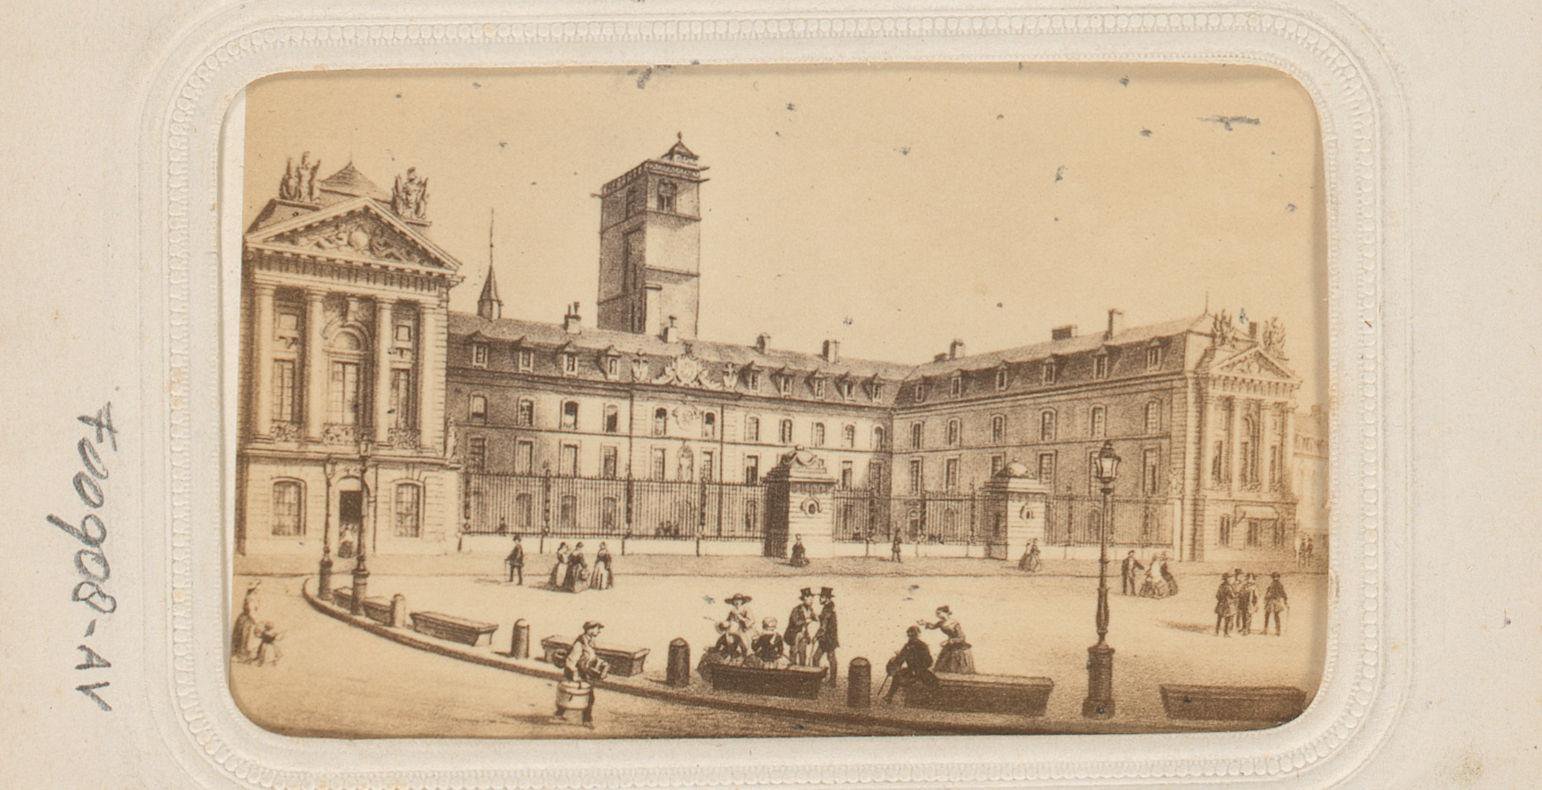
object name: reproduction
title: Fotoreproductie van een prent van het Paleis van de hertogen van Bourgondië te Dijon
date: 1860-1885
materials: cardboard, photographic support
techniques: albumen print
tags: palace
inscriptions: annotation: ‘Paleis der hertogen van Bourgondië te Dijon’, annotation: ‘Palais des ducs de Bourgogne Dijon’, inscription: ‘Photographie de Chardon jeune,/ 3 Rue Racine, Paris’, inscription: ‘E. Morier/ Editeur/ Rue St. André des Arts 52/ Paris’